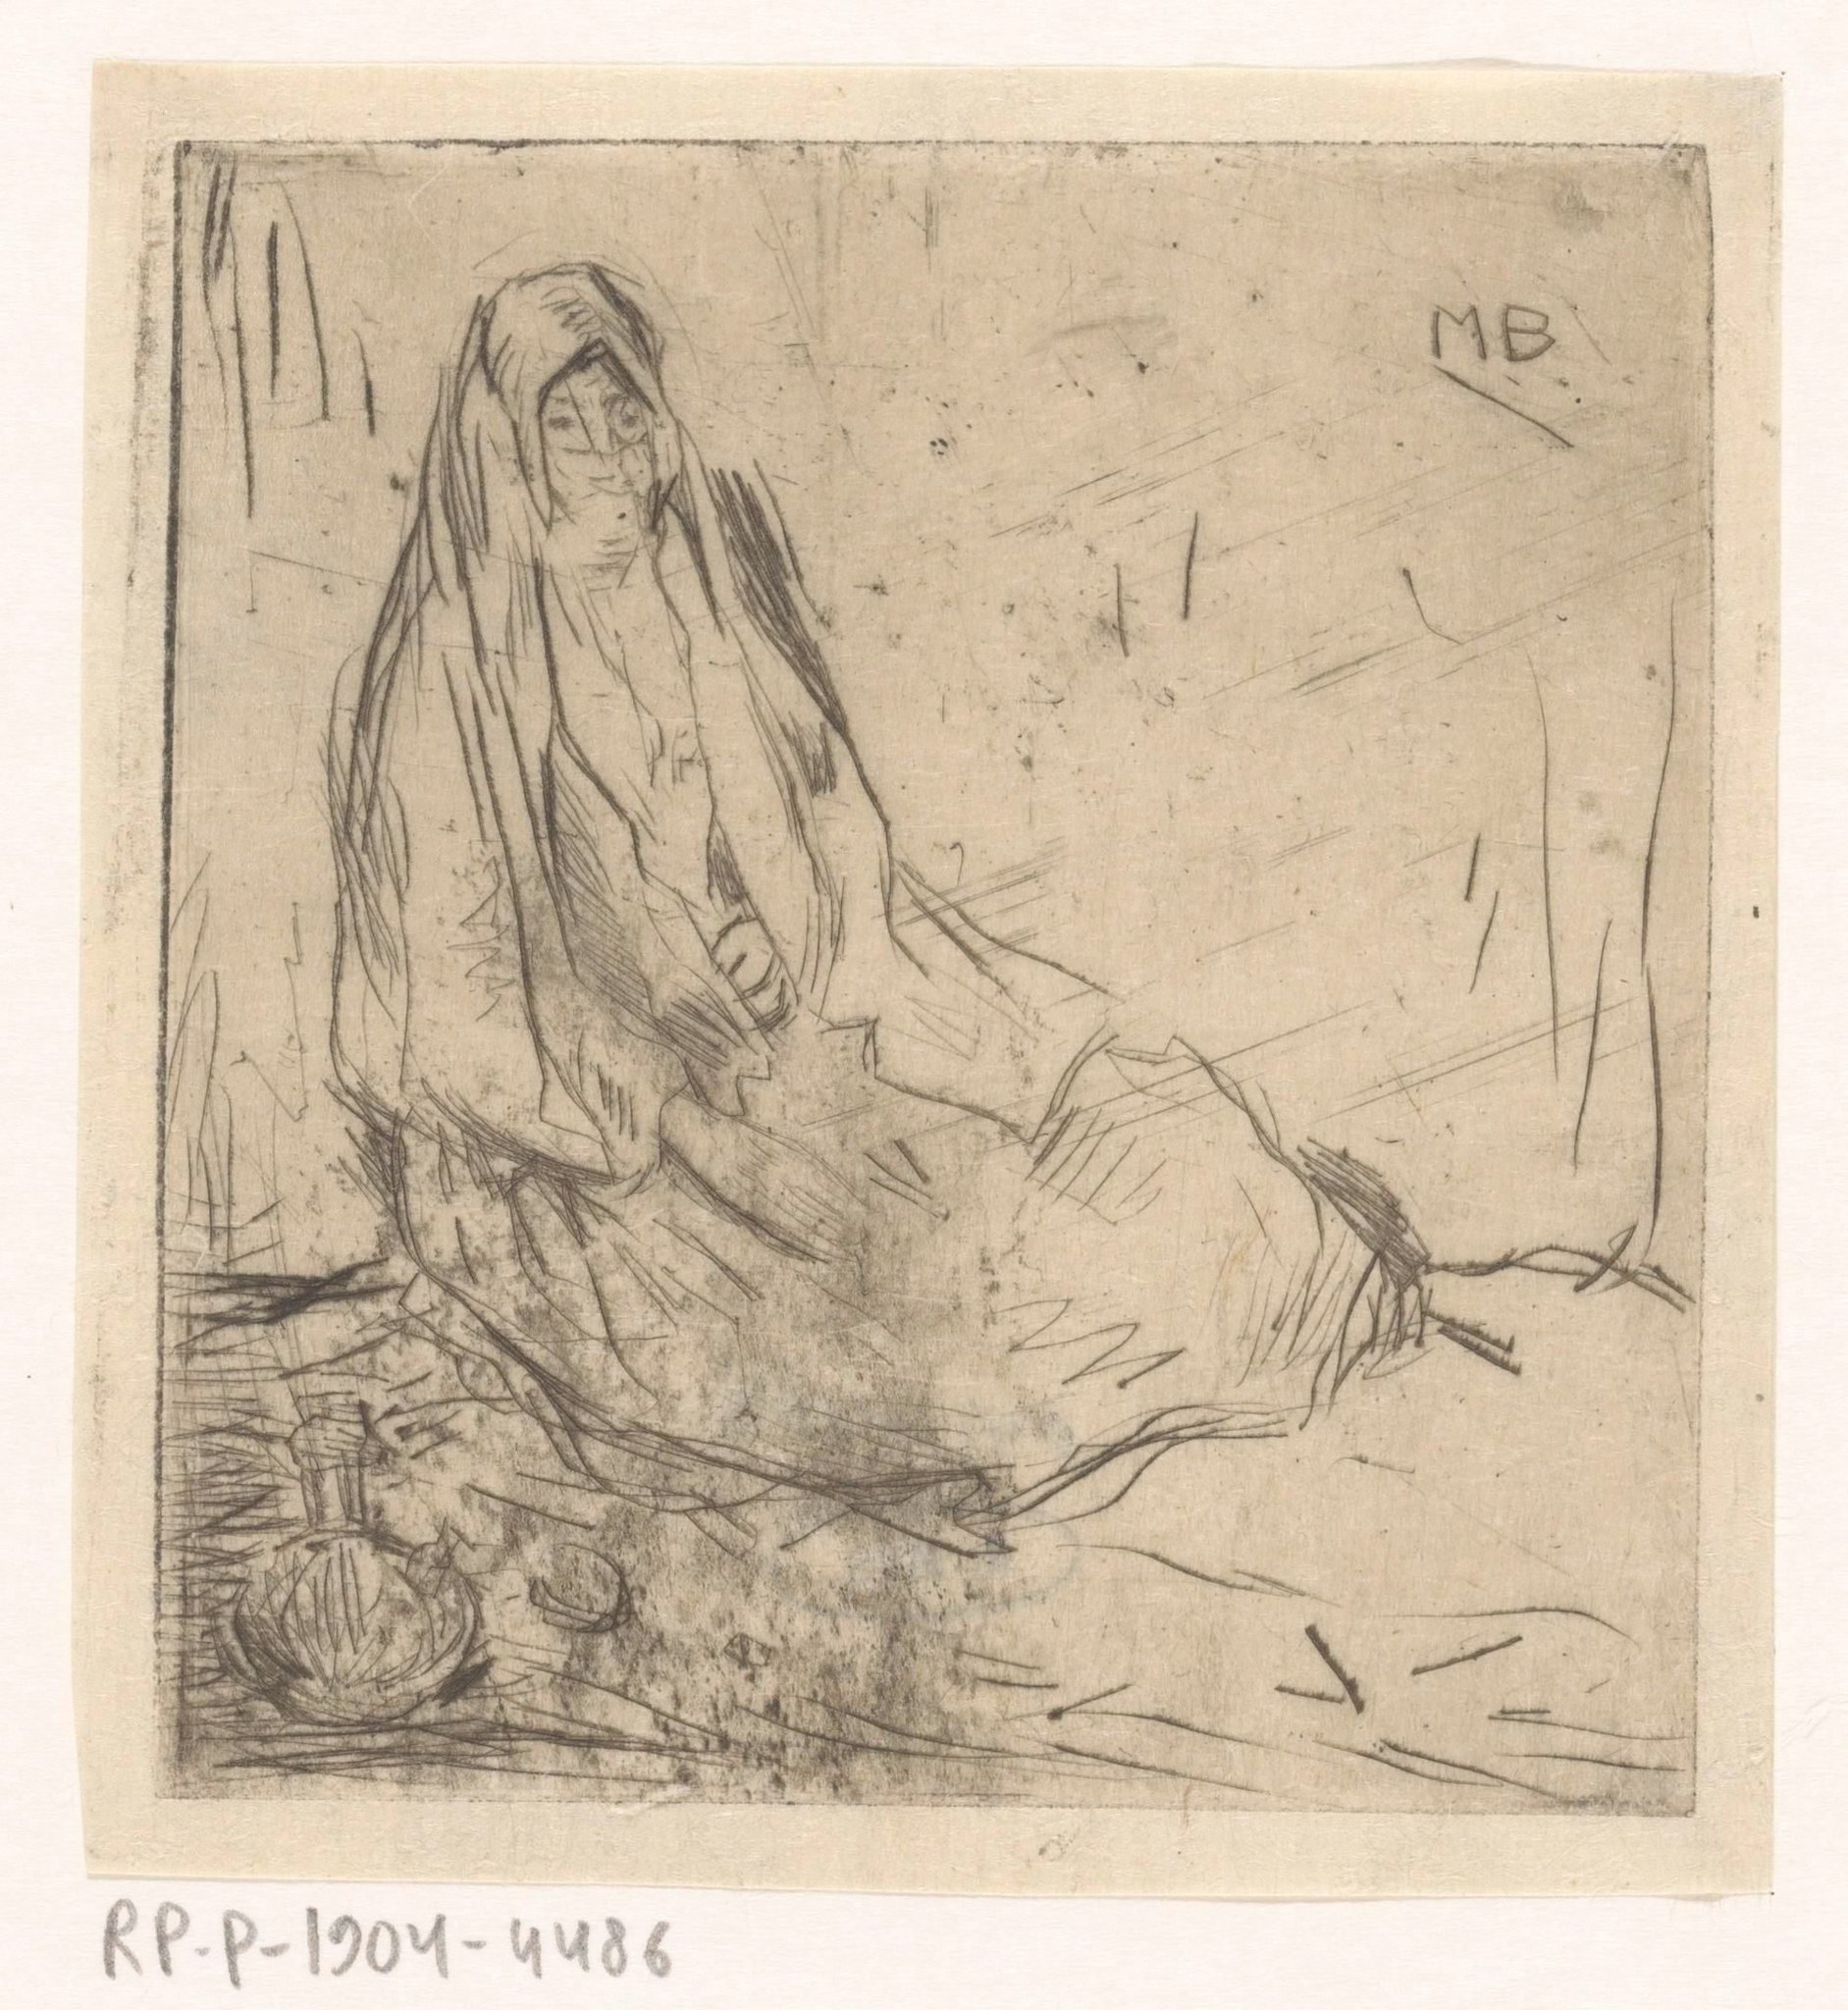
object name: print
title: Zittende, gesluierde vrouw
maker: marius bauer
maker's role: draughtsman, print maker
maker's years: 1867-1932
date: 1877-1904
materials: paper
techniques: etching, intaglio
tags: veil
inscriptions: collector's mark: Lugt 2228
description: Een zittende, gesluierde vrouw. Links op de voorgrond een karaf.